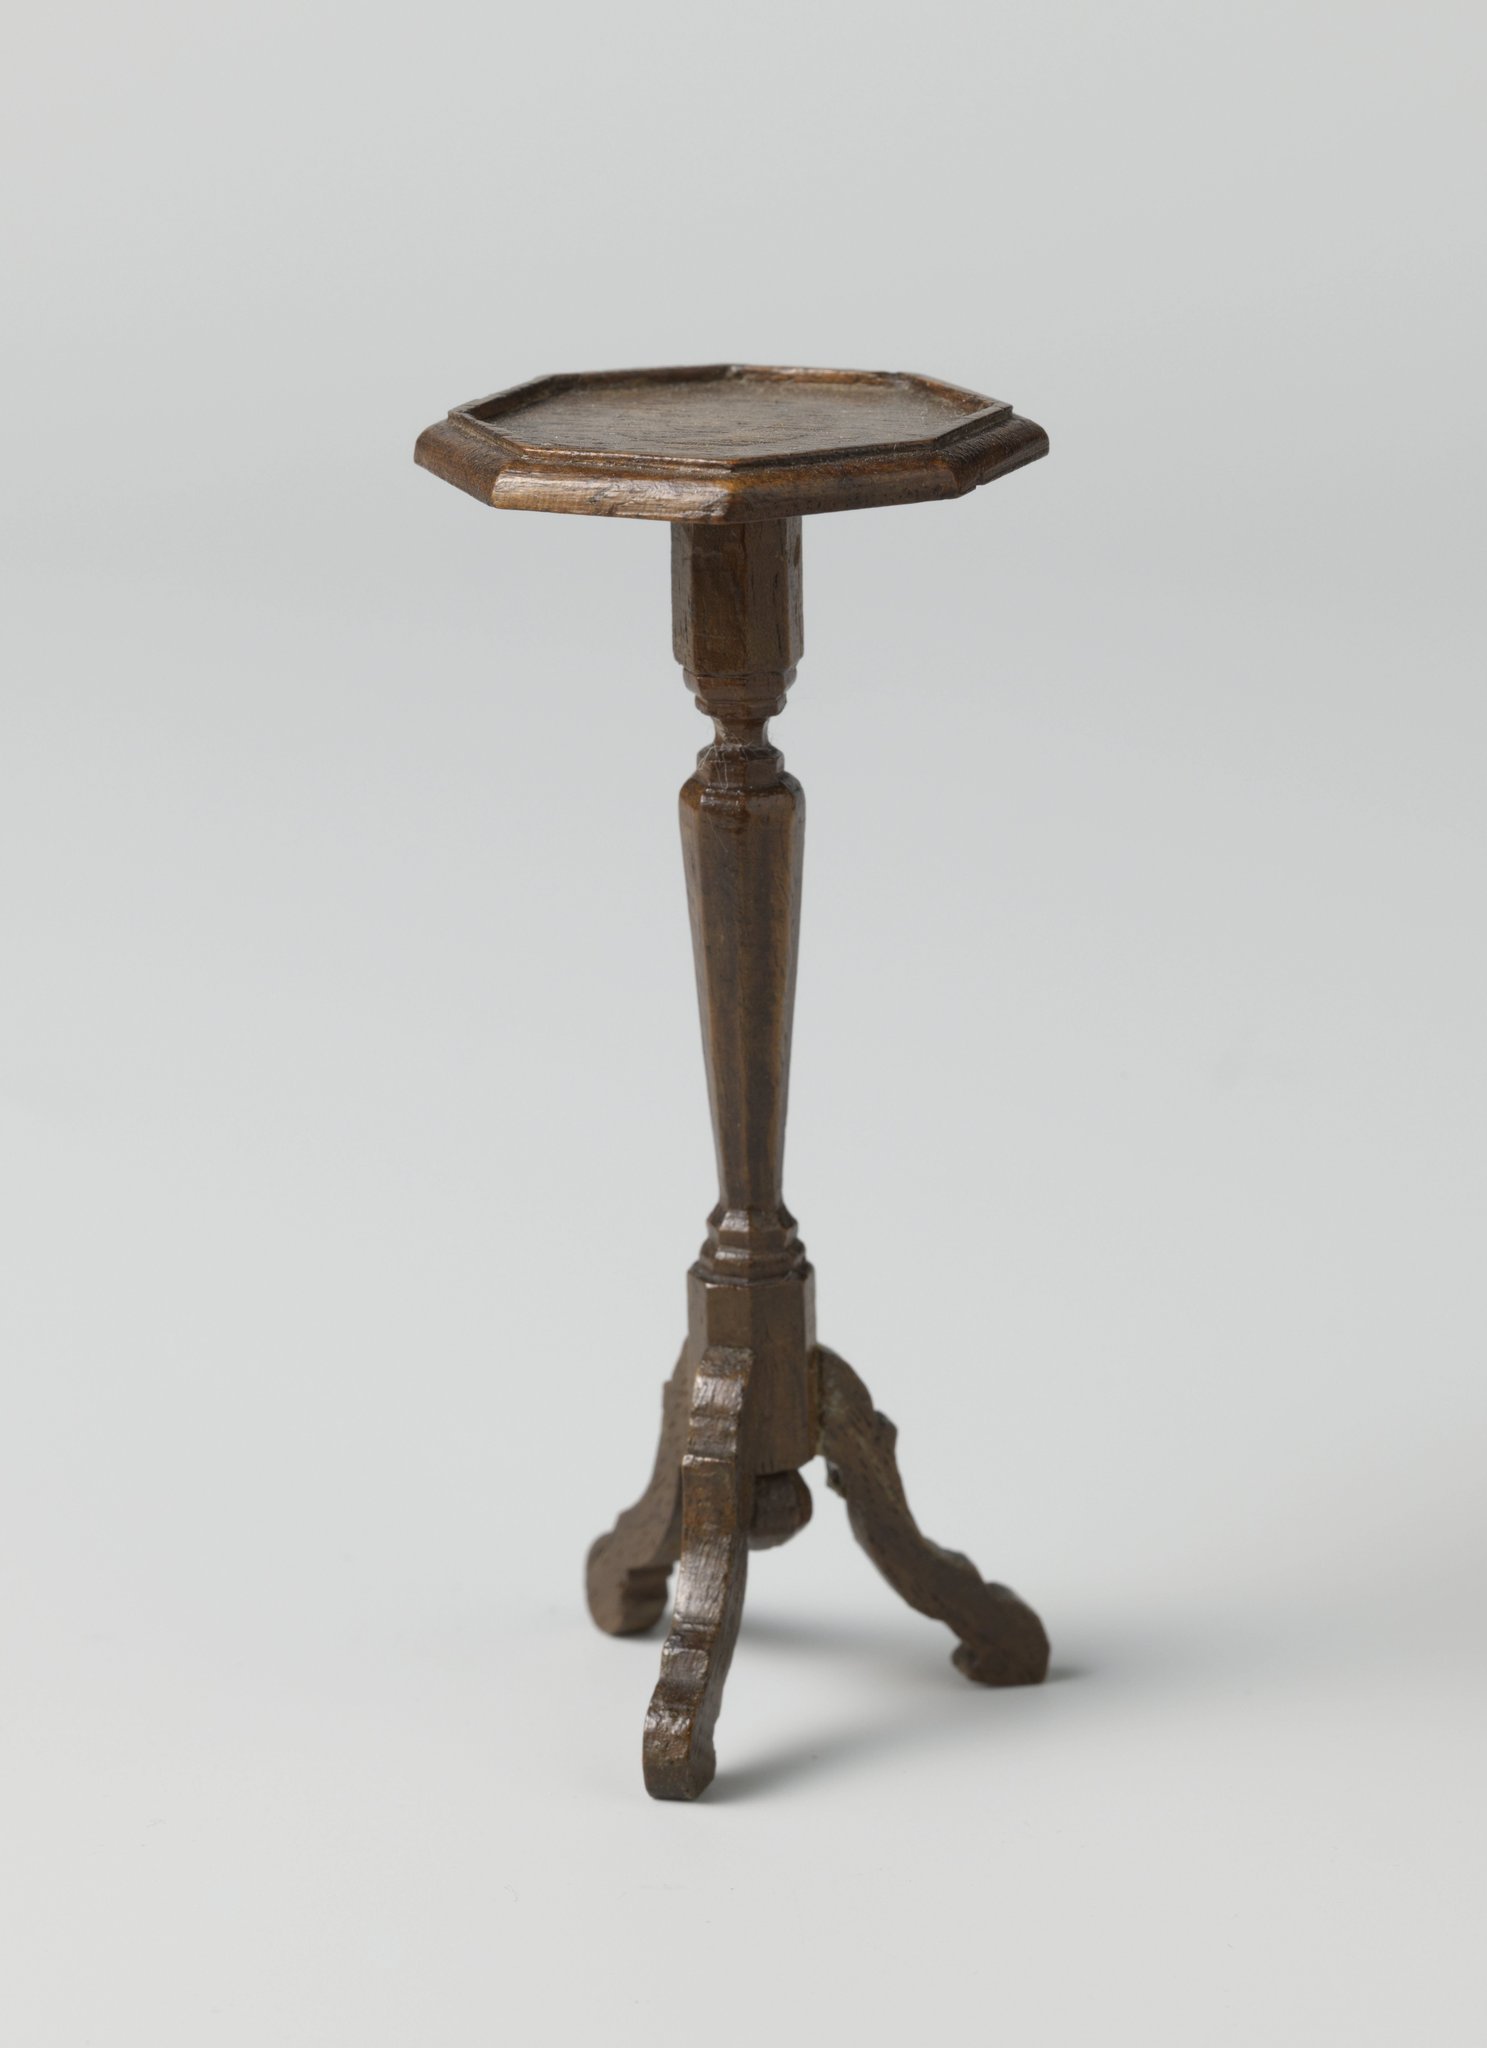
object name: guéridon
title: Gueridon met achthoekig blad, op taps toelopende, geprofileerde stam op drie s-vormige poten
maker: Anonymous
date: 1750-1800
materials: wood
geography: amsterdam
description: Gueridon van notenhout, met achthoekig blad met opstaande rand, op taps toelopende, geprofileerde stam op drie s-vormige poten.